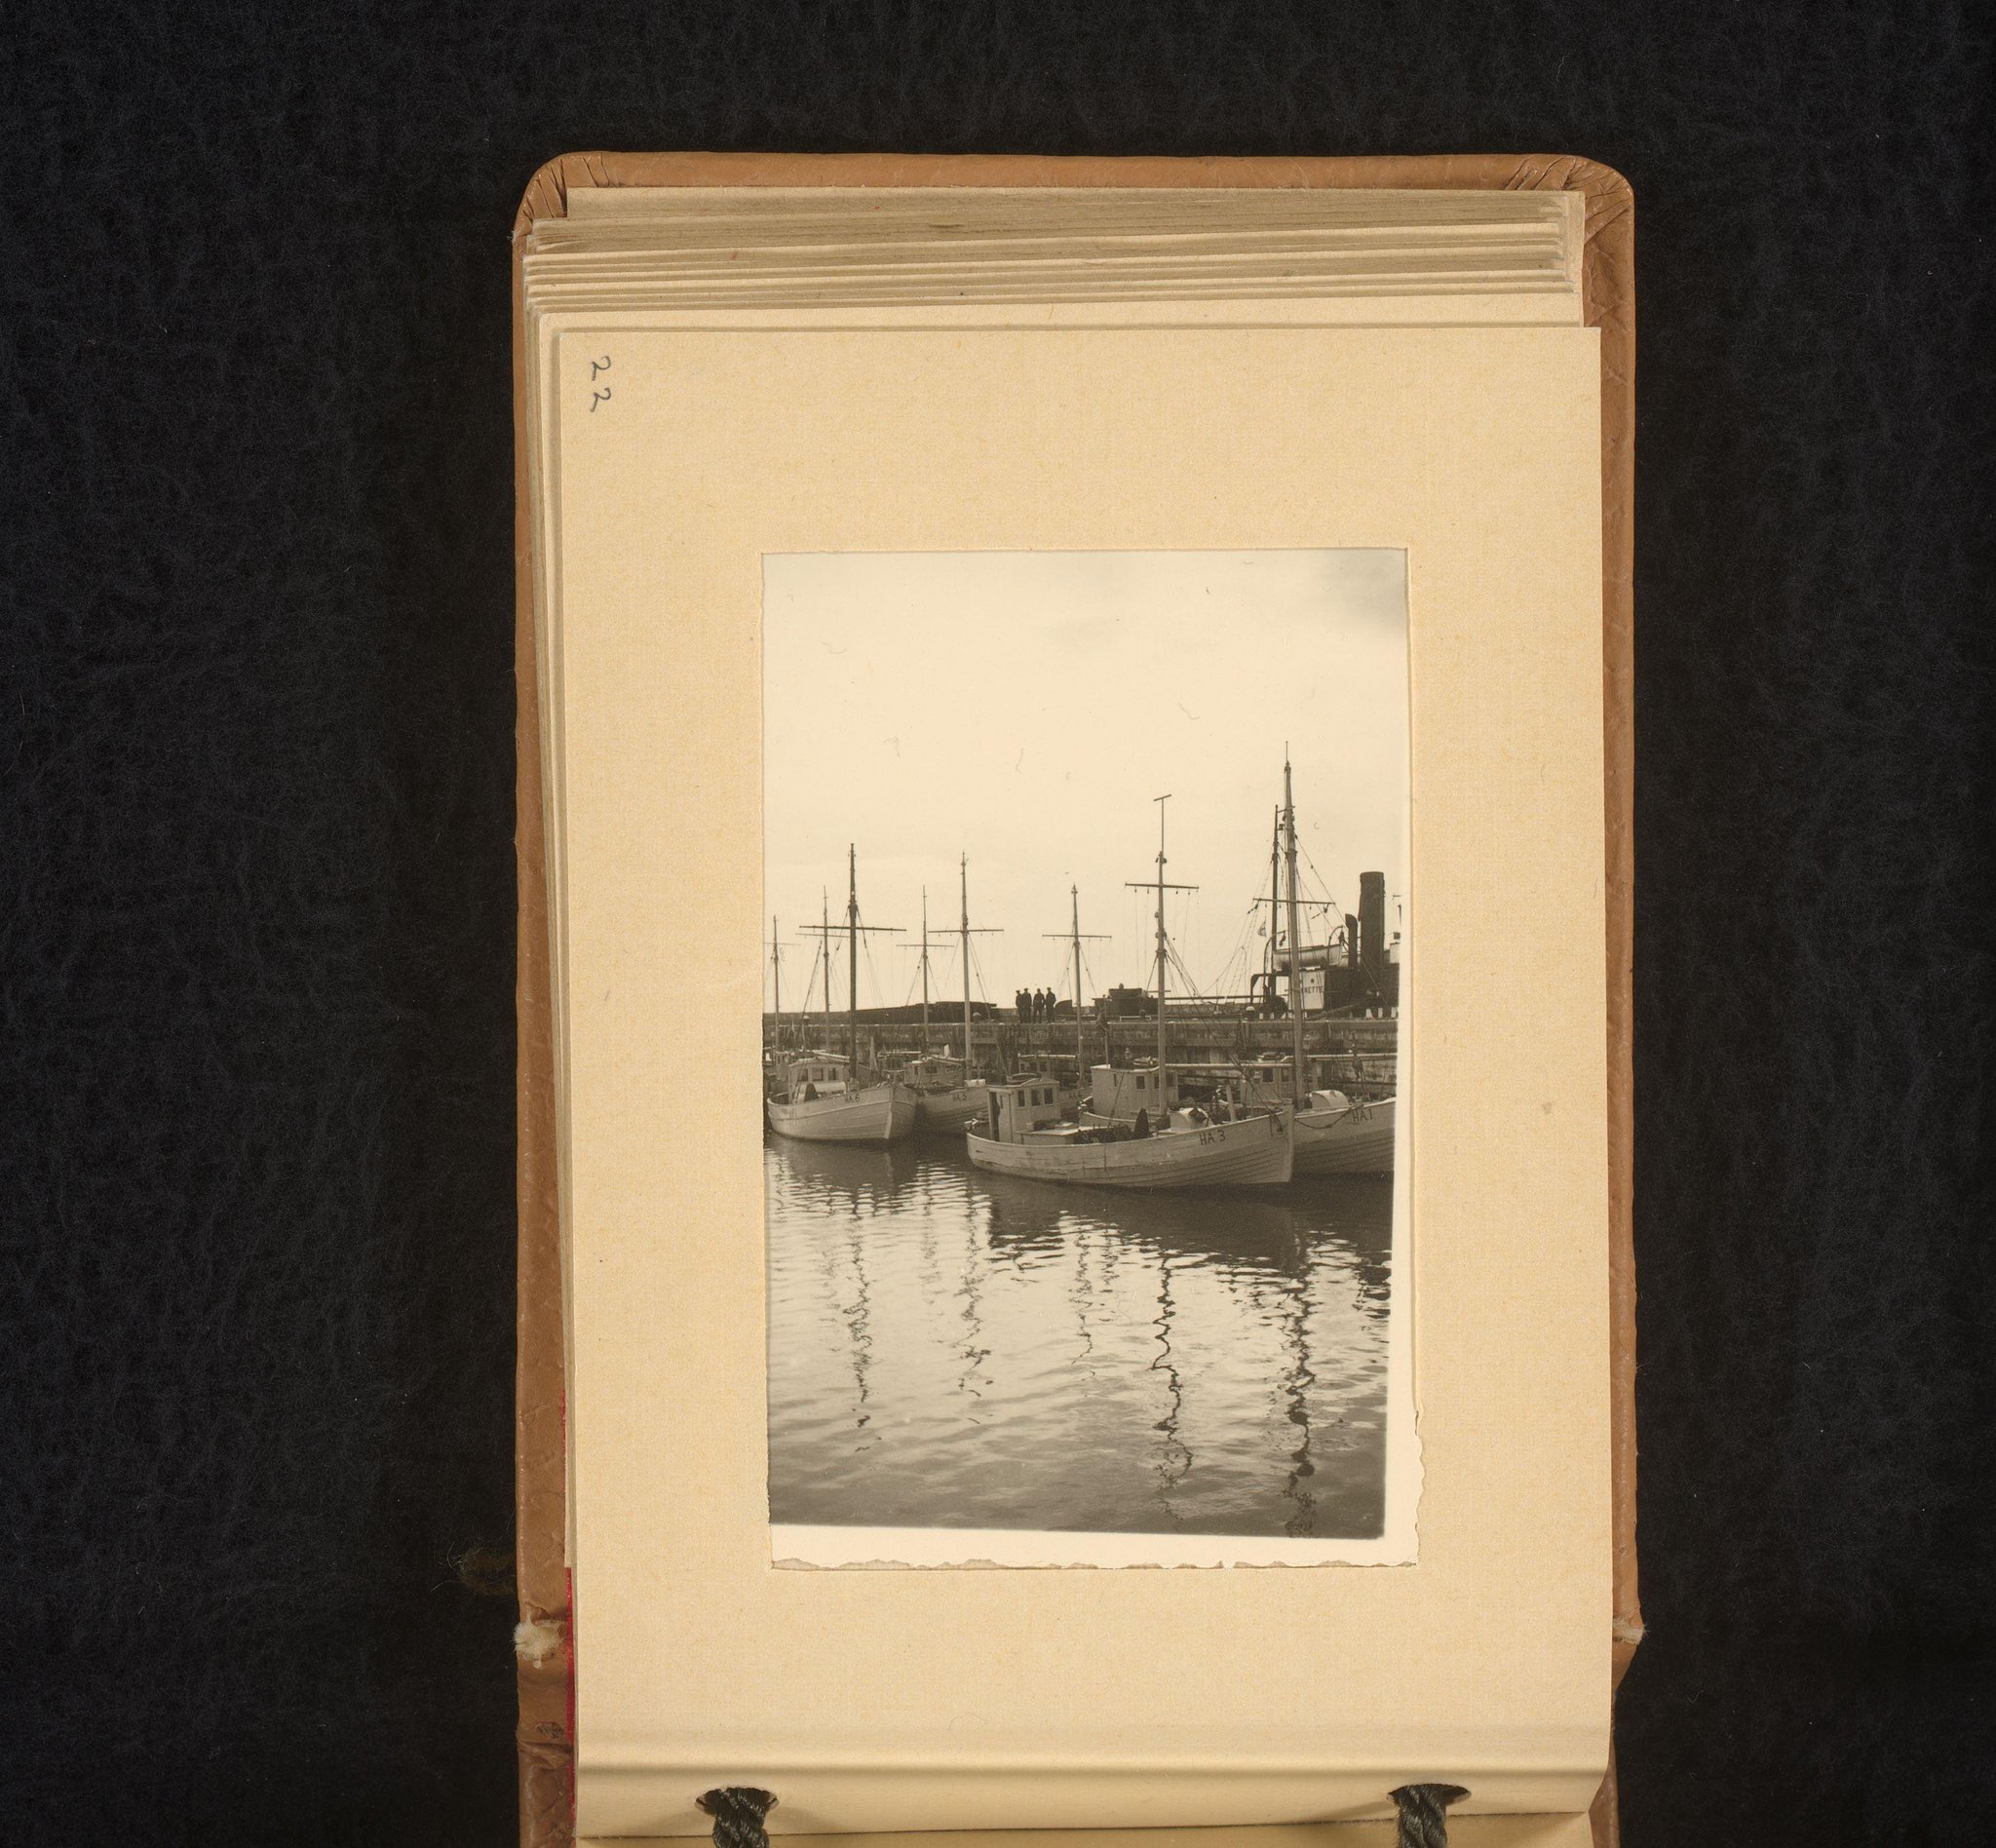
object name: photograph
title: Schepen van de Kriegsmarine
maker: Anonymous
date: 1940-1943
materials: paper, photographic support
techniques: gelatin silver print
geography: netherlands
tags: navy (+ motor ships), occupation ~ war, quay, netherlands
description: Albumblad met een foto van een aantal kleine schepen van de Kriegsmarine, aangemeerd aan een kade. Onderdeel van een klein album van de Kriegsmarine in Nederland.